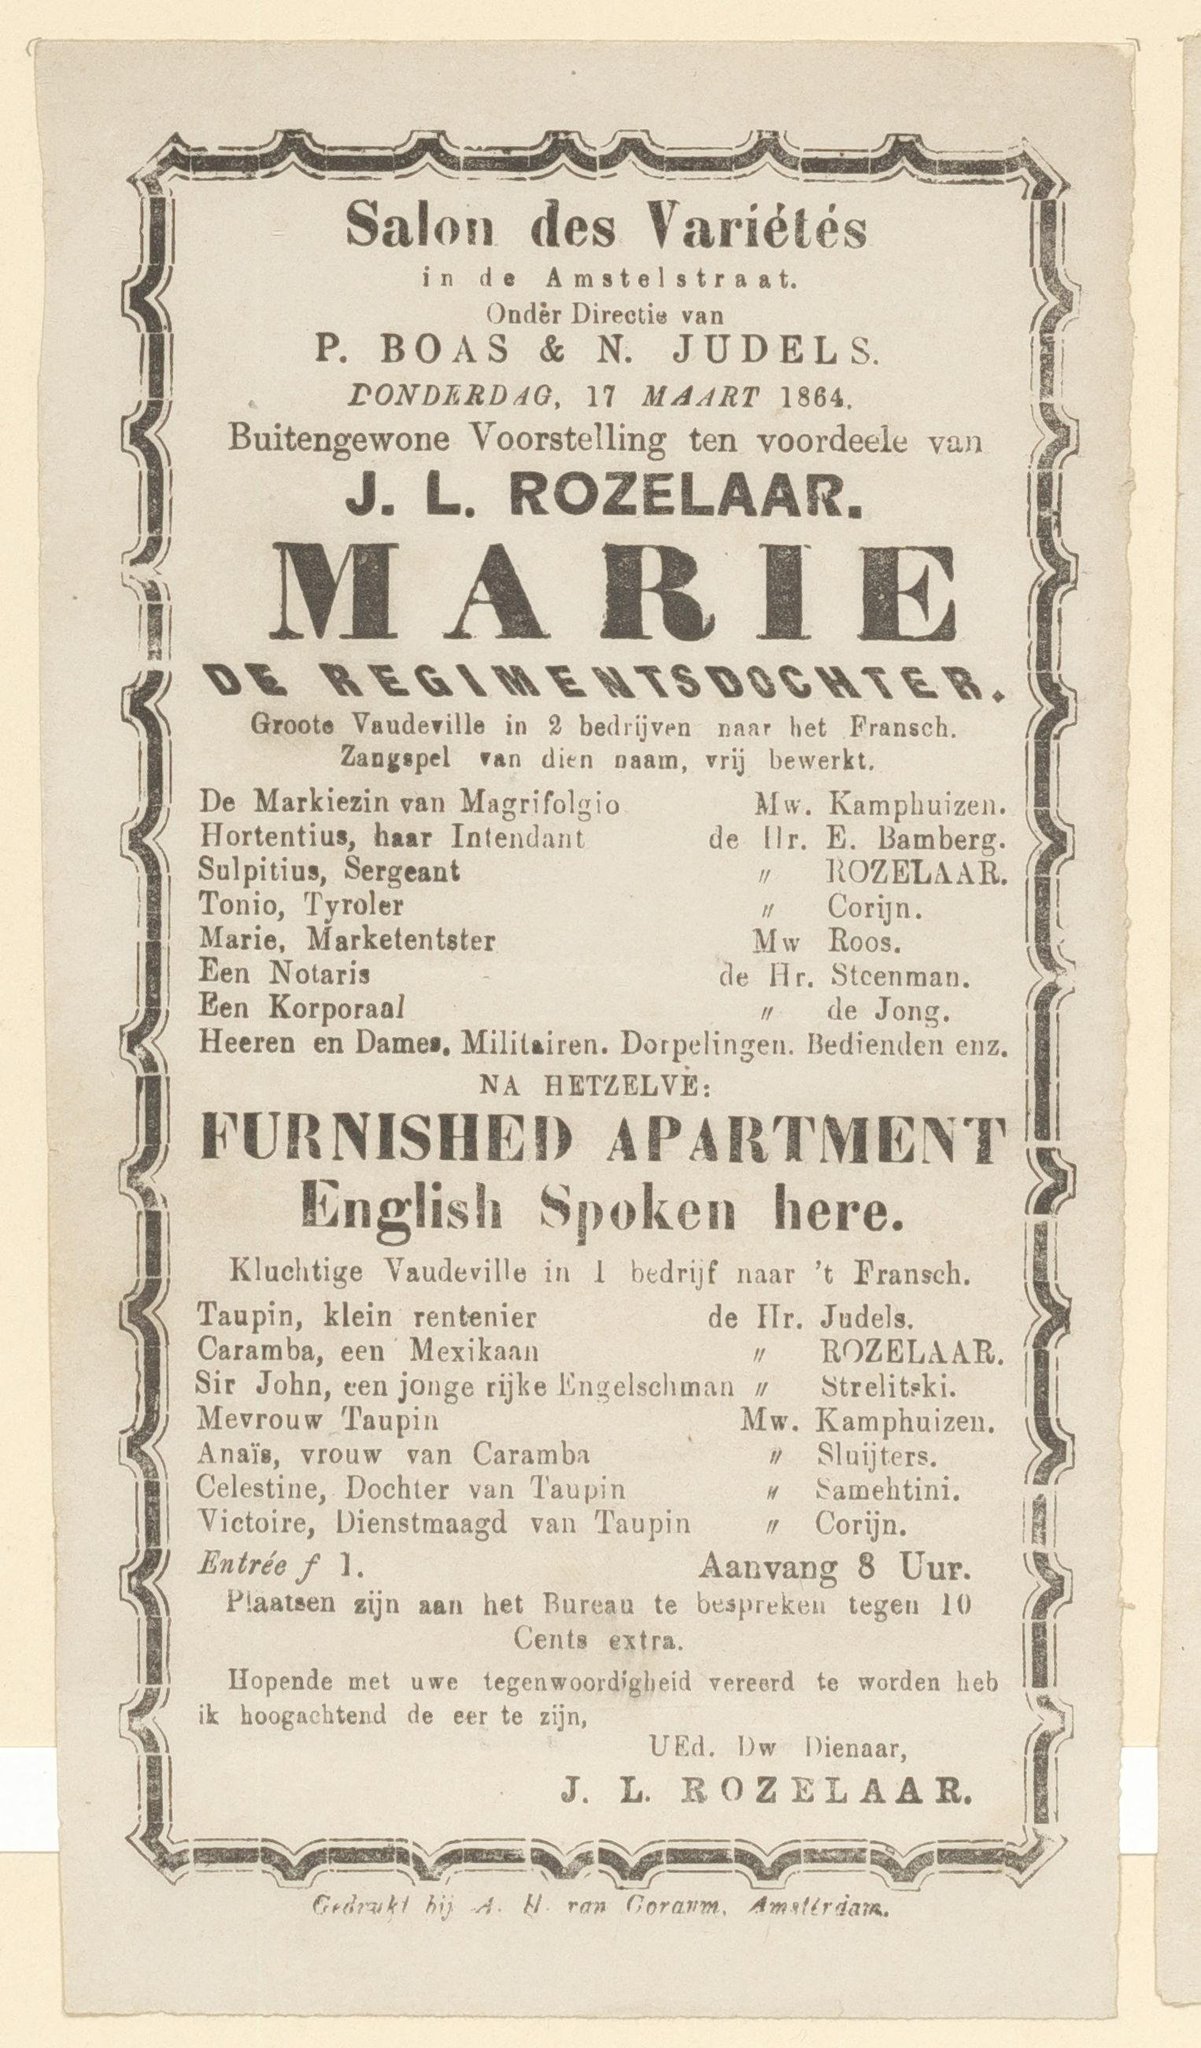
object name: text sheet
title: Marie de regimentsdochter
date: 1864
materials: paper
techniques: letterpress printing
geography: amsterdam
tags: theatre, theatrical performance, art, amsterdam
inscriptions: collector's mark: Lugt 1641, stamp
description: Aankondiging van de voorstelling De Marie de regimentsdochter en Furnished apartment op 17 maart 1864. Onderwerpsrubrieken binnen de Atlas Zeden en Gewoonten: Tooneel, Toneelprogramma’s.